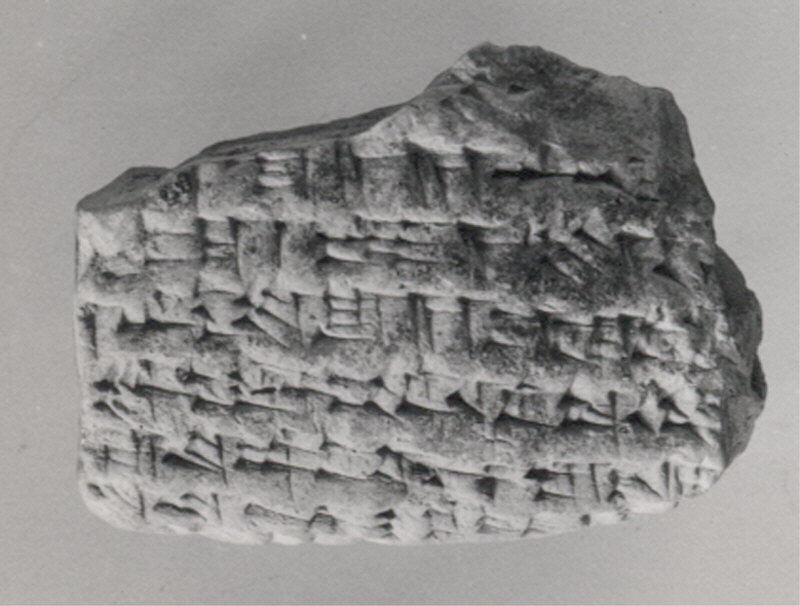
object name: cuneiform tablet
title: Cuneiform tablet: promissory note for barley, Esagilaya archive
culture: babylonian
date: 555-539 BCE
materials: clay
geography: mesopotamia